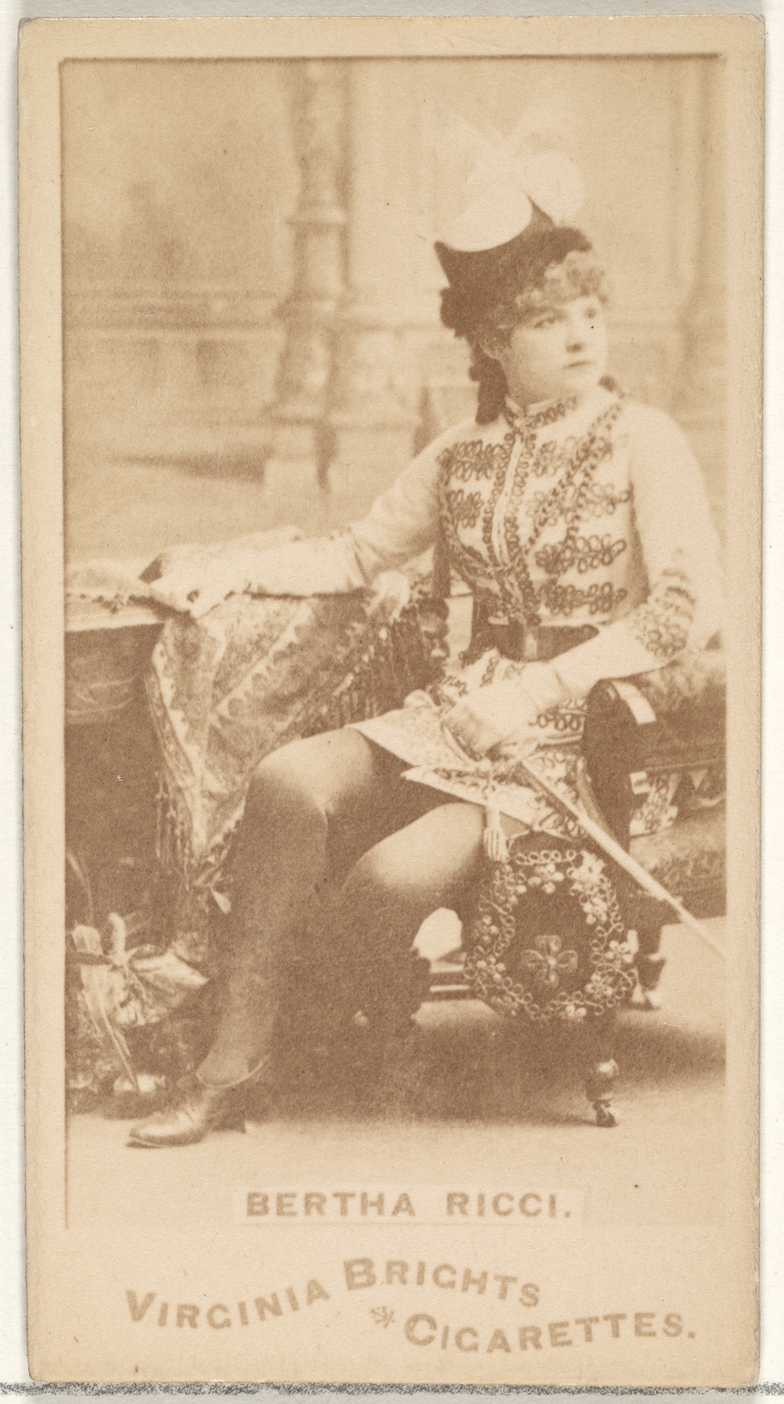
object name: photograph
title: Bertha Ricci, from the Actors and Actresses series (N45, Type 1) for Virginia Brights Cigarettes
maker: allen & ginter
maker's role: publisher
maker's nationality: american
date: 1888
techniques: albumen silver print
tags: portraits,women,actresses